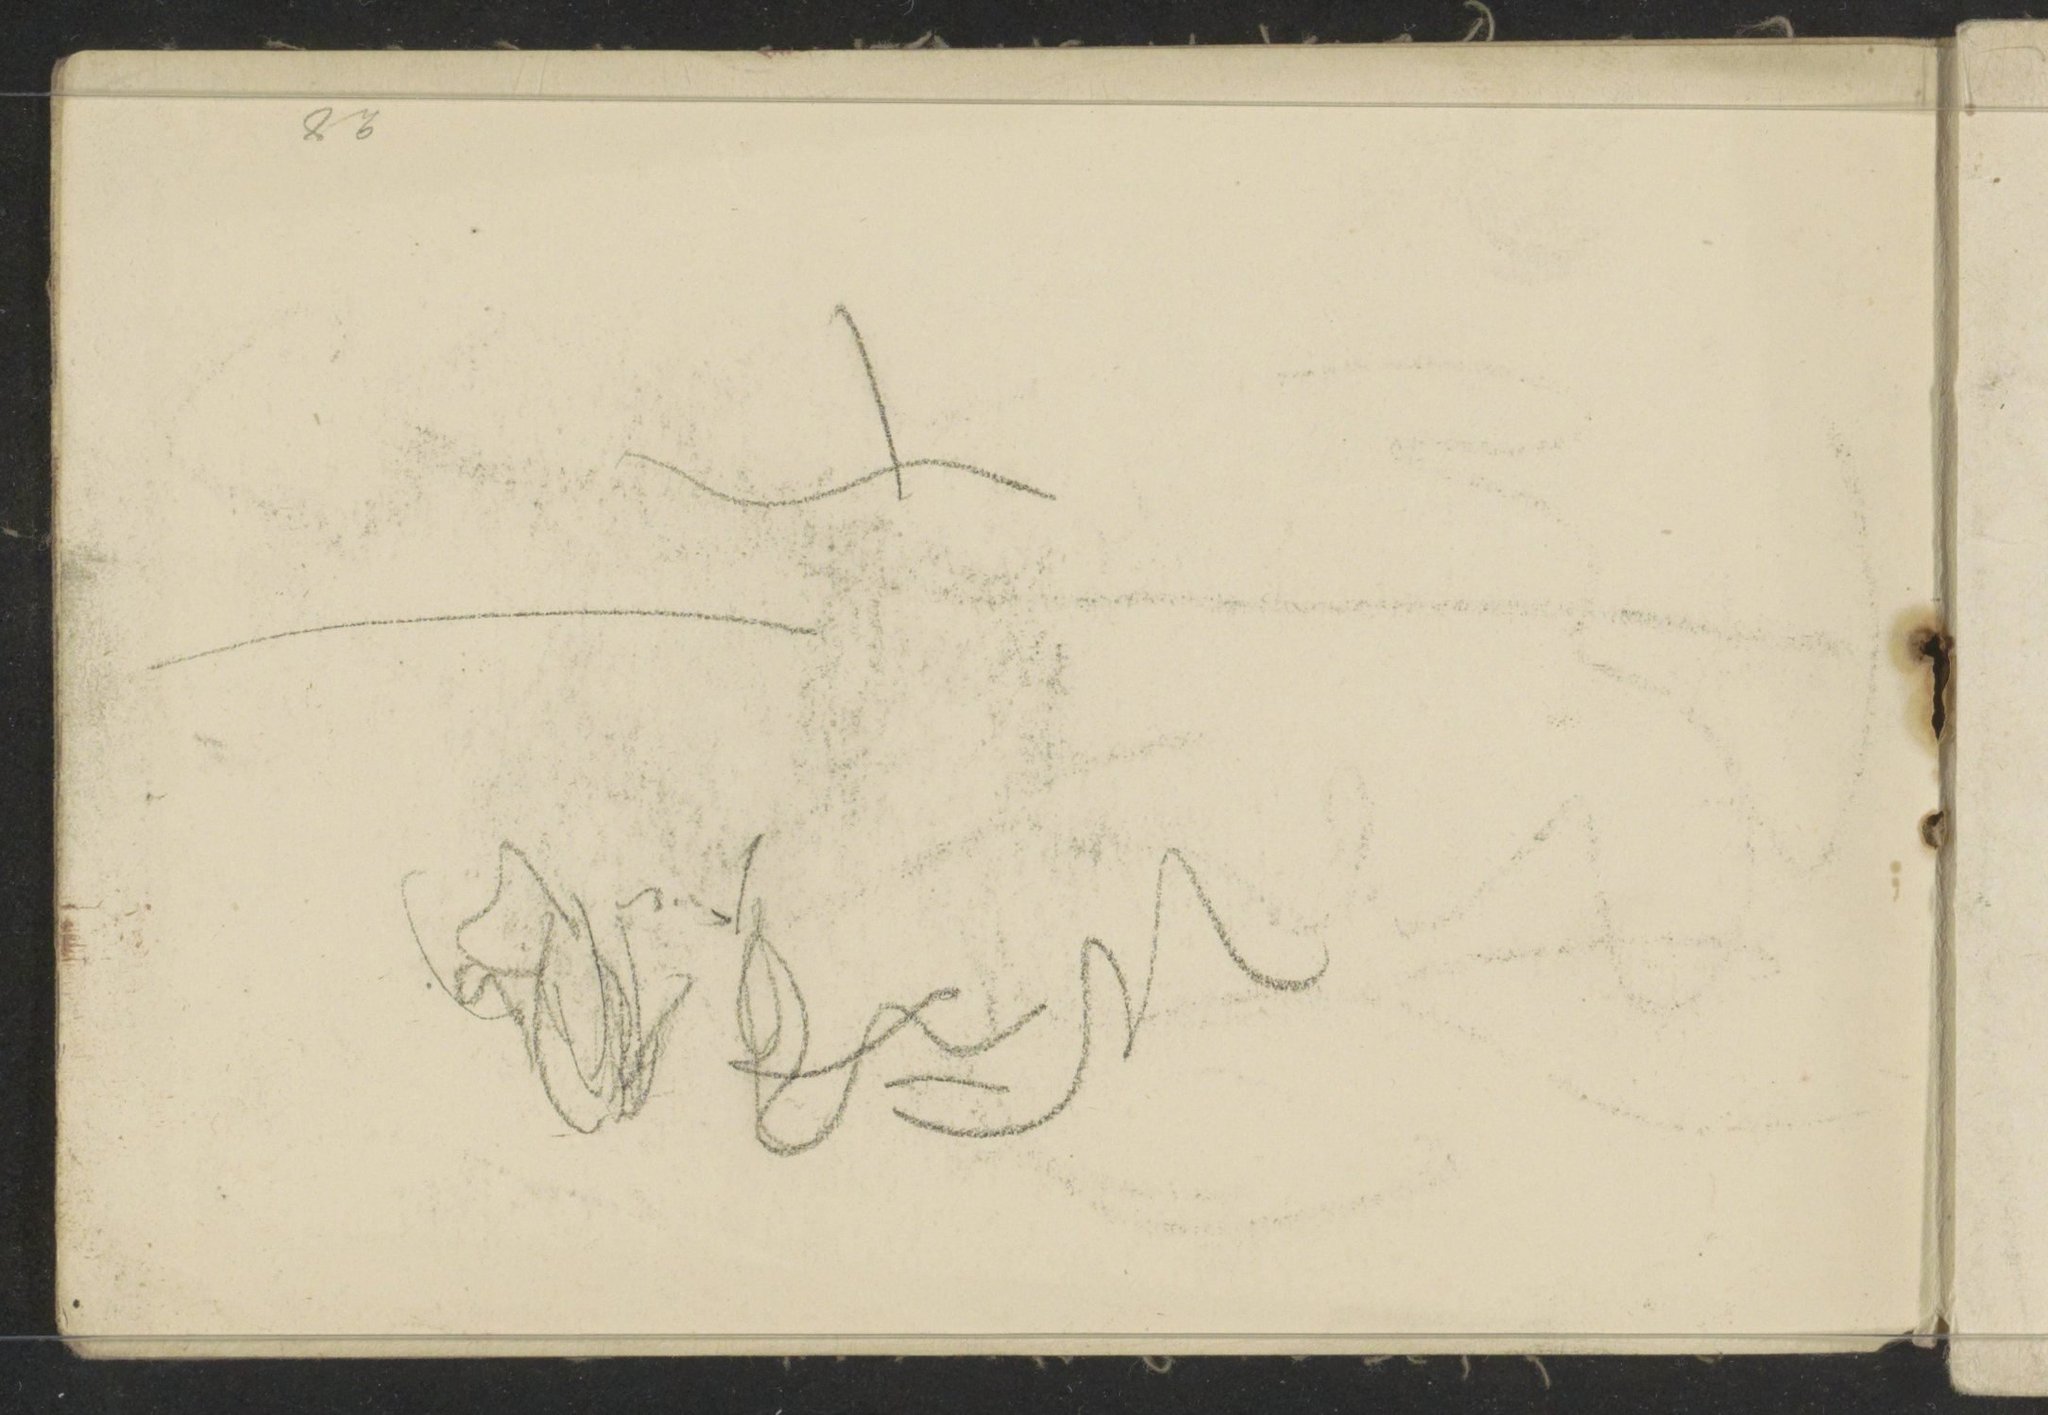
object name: sketchbook leaf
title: Vrouw met hoed, in profiel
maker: isaac israels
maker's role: draughtsman, painter, print maker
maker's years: 1865-1934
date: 1923-1934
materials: chalk, paper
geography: the hague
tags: head-gear: hat (+ women's clothes), adult woman (+ sideview, profile)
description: Blad 1 verso uit schetsboek LVIII met 14 bladen.